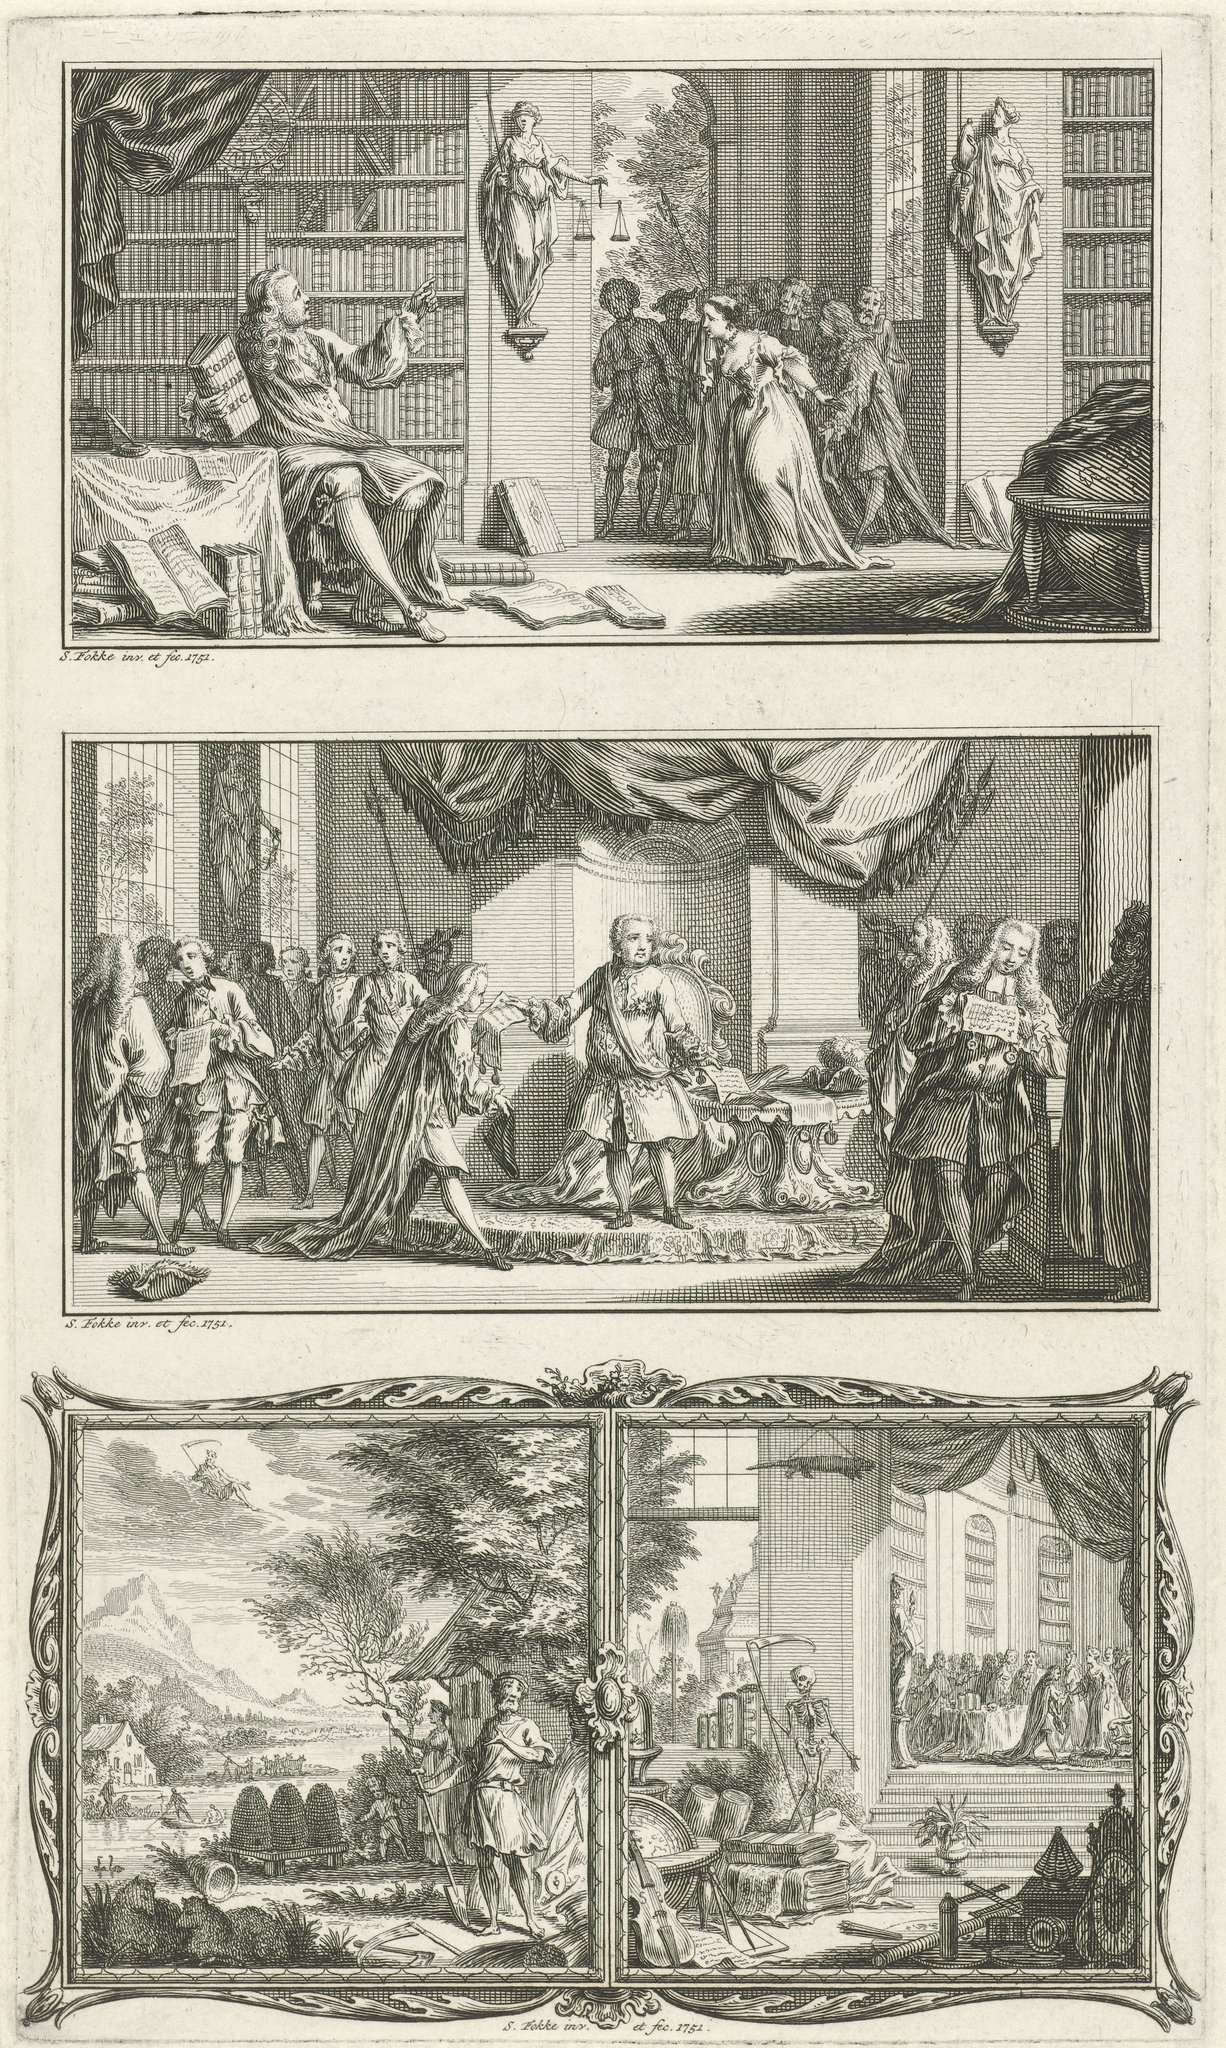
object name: print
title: Man in een bibliotheek / Uitwisseling van documenten / Platteland en skelet met sikkel bij huwelijksvoltrekking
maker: simon fokke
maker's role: draughtsman, print maker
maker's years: 1712-1784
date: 1751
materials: paper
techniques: etching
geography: amsterdam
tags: justice, 'justitia'; 'giustitia divina' (ripa) ~ one of the four cardinal virtues, marriage, married couple, 'matrimonium', marriage contract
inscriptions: collector's mark: Lugt 240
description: Drie illustraties boven elkaar van één plaat. Boven: Een vrouw wordt door een groep mannen een bibliotheek binnengebracht, waarin zich een man met boek en het beeld van Vrouw Justitia bevinden. Midden: Uitwisseling van documenten tussen diverse mannen. Onder: Figuur met sikkel op platteland. Rechts een skelet met eveneens een sikkel naast een huwelijksvoltrekking.